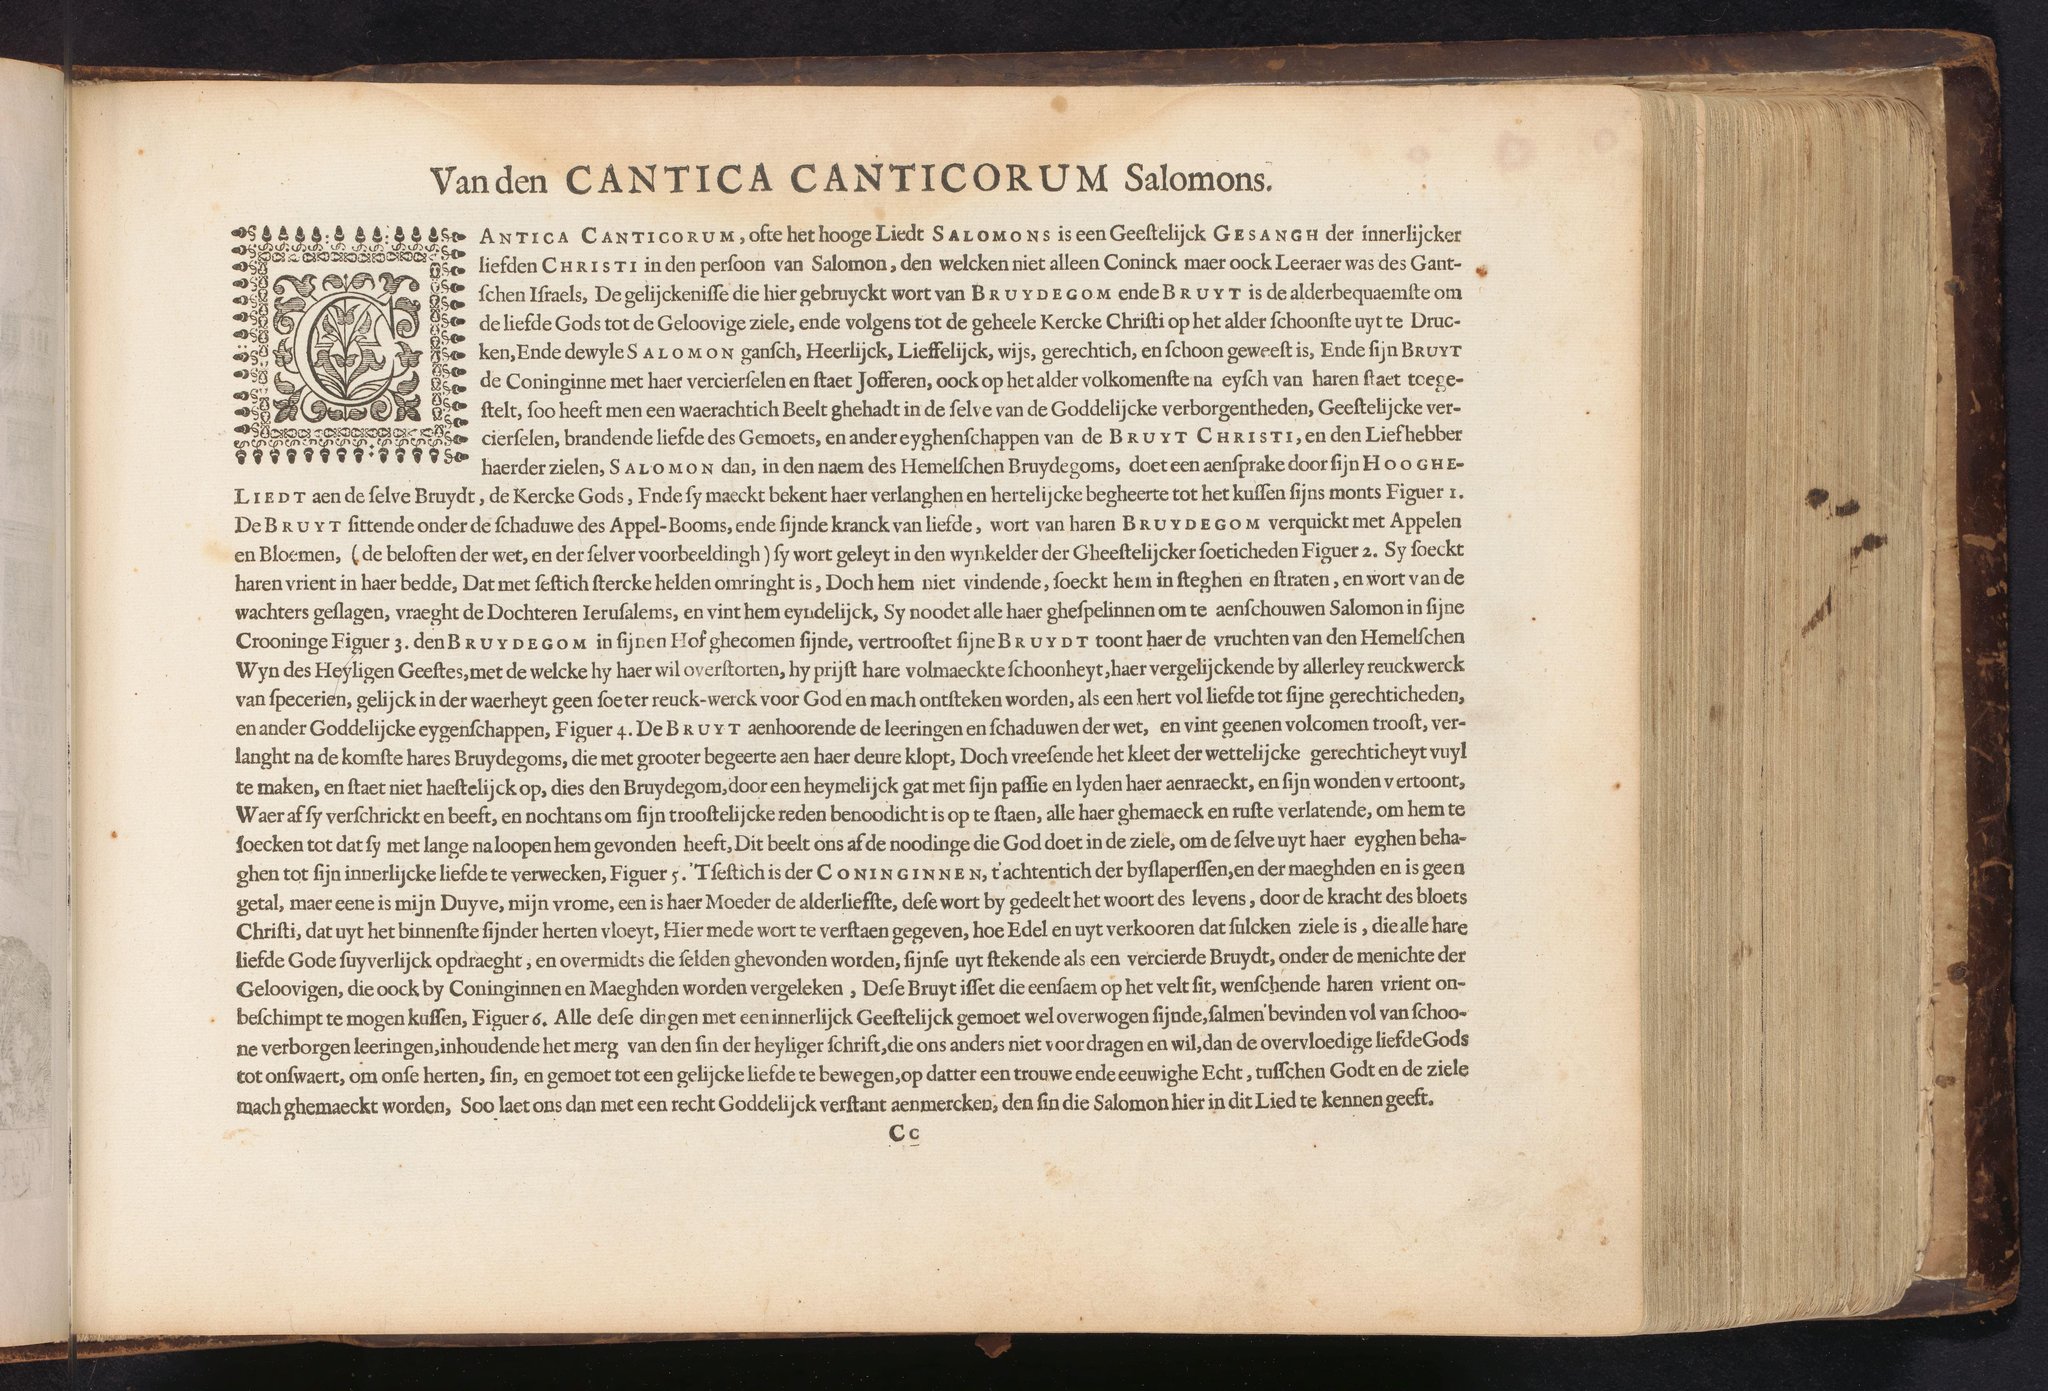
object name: text sheet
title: Van den Cantica Canticorum Salomons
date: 1646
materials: paper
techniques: letterpress printing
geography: alkmaar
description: Tekstblad bij een serie prenten over het Hooglied van Salomo. Linksboven initiaal C. Dit blad maakt deel uit van een album.